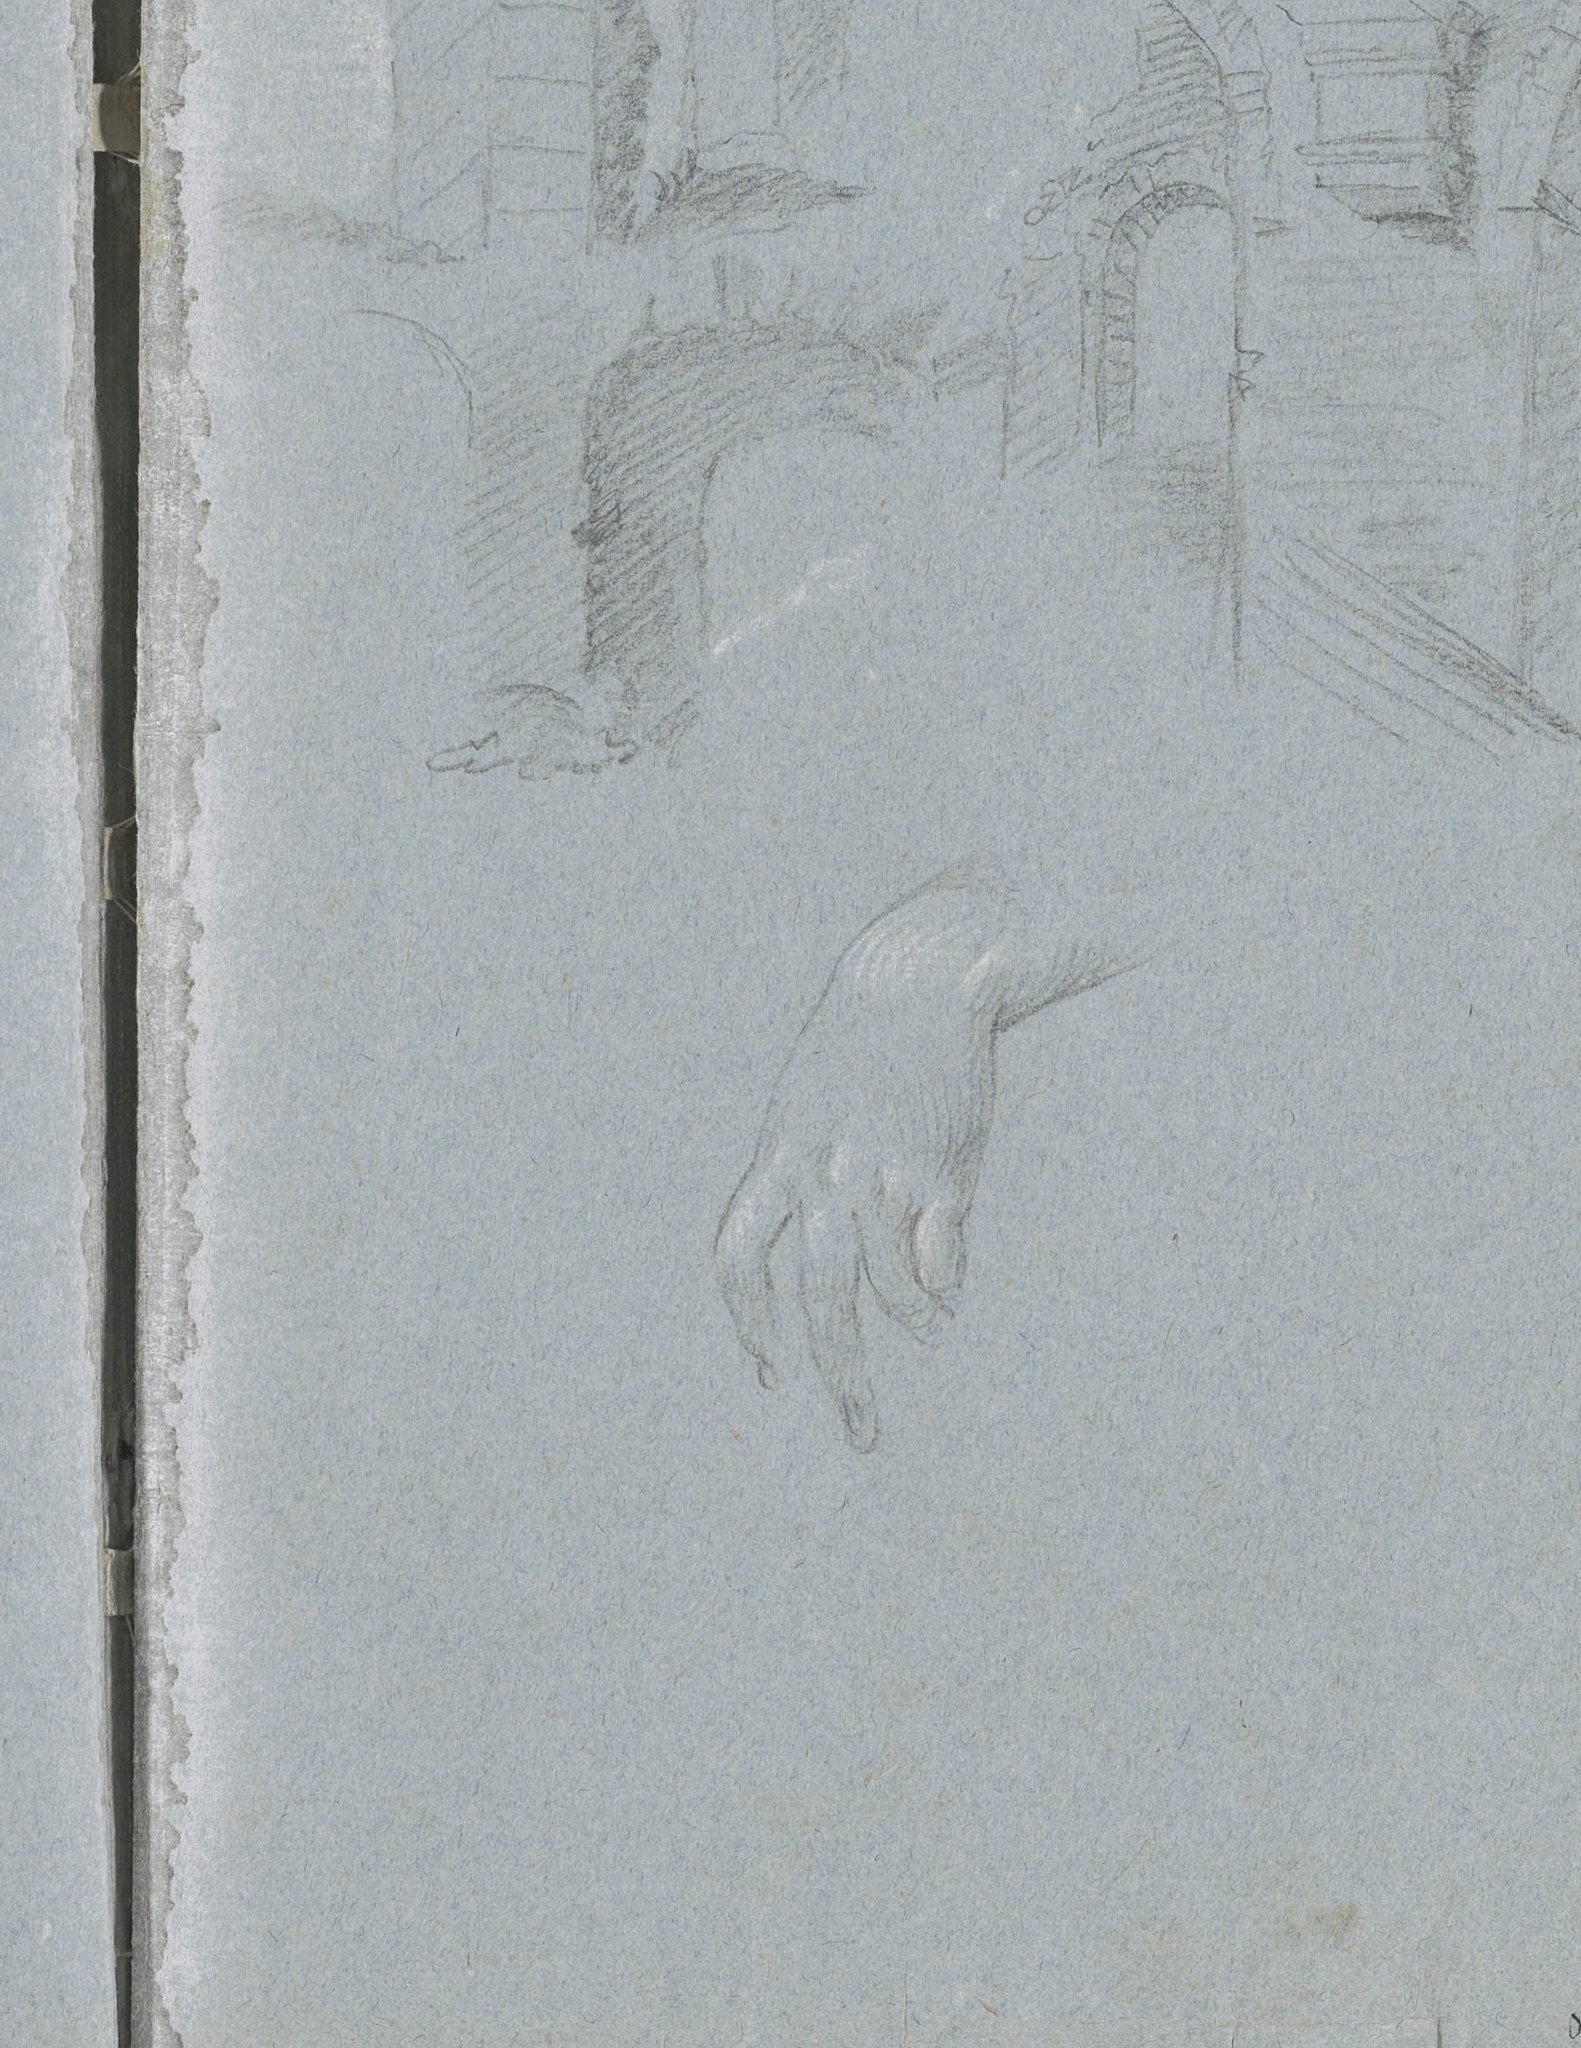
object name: sketchbook leaf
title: Arcaden en een hand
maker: lorenzo baldissera tiepolo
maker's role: draughtsman, print maker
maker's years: 1736-1776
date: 1751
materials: chalk, paper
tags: hand, arcade ~ architecture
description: Bladzijde 73 uit een schetsboek met 158 bladzijden.